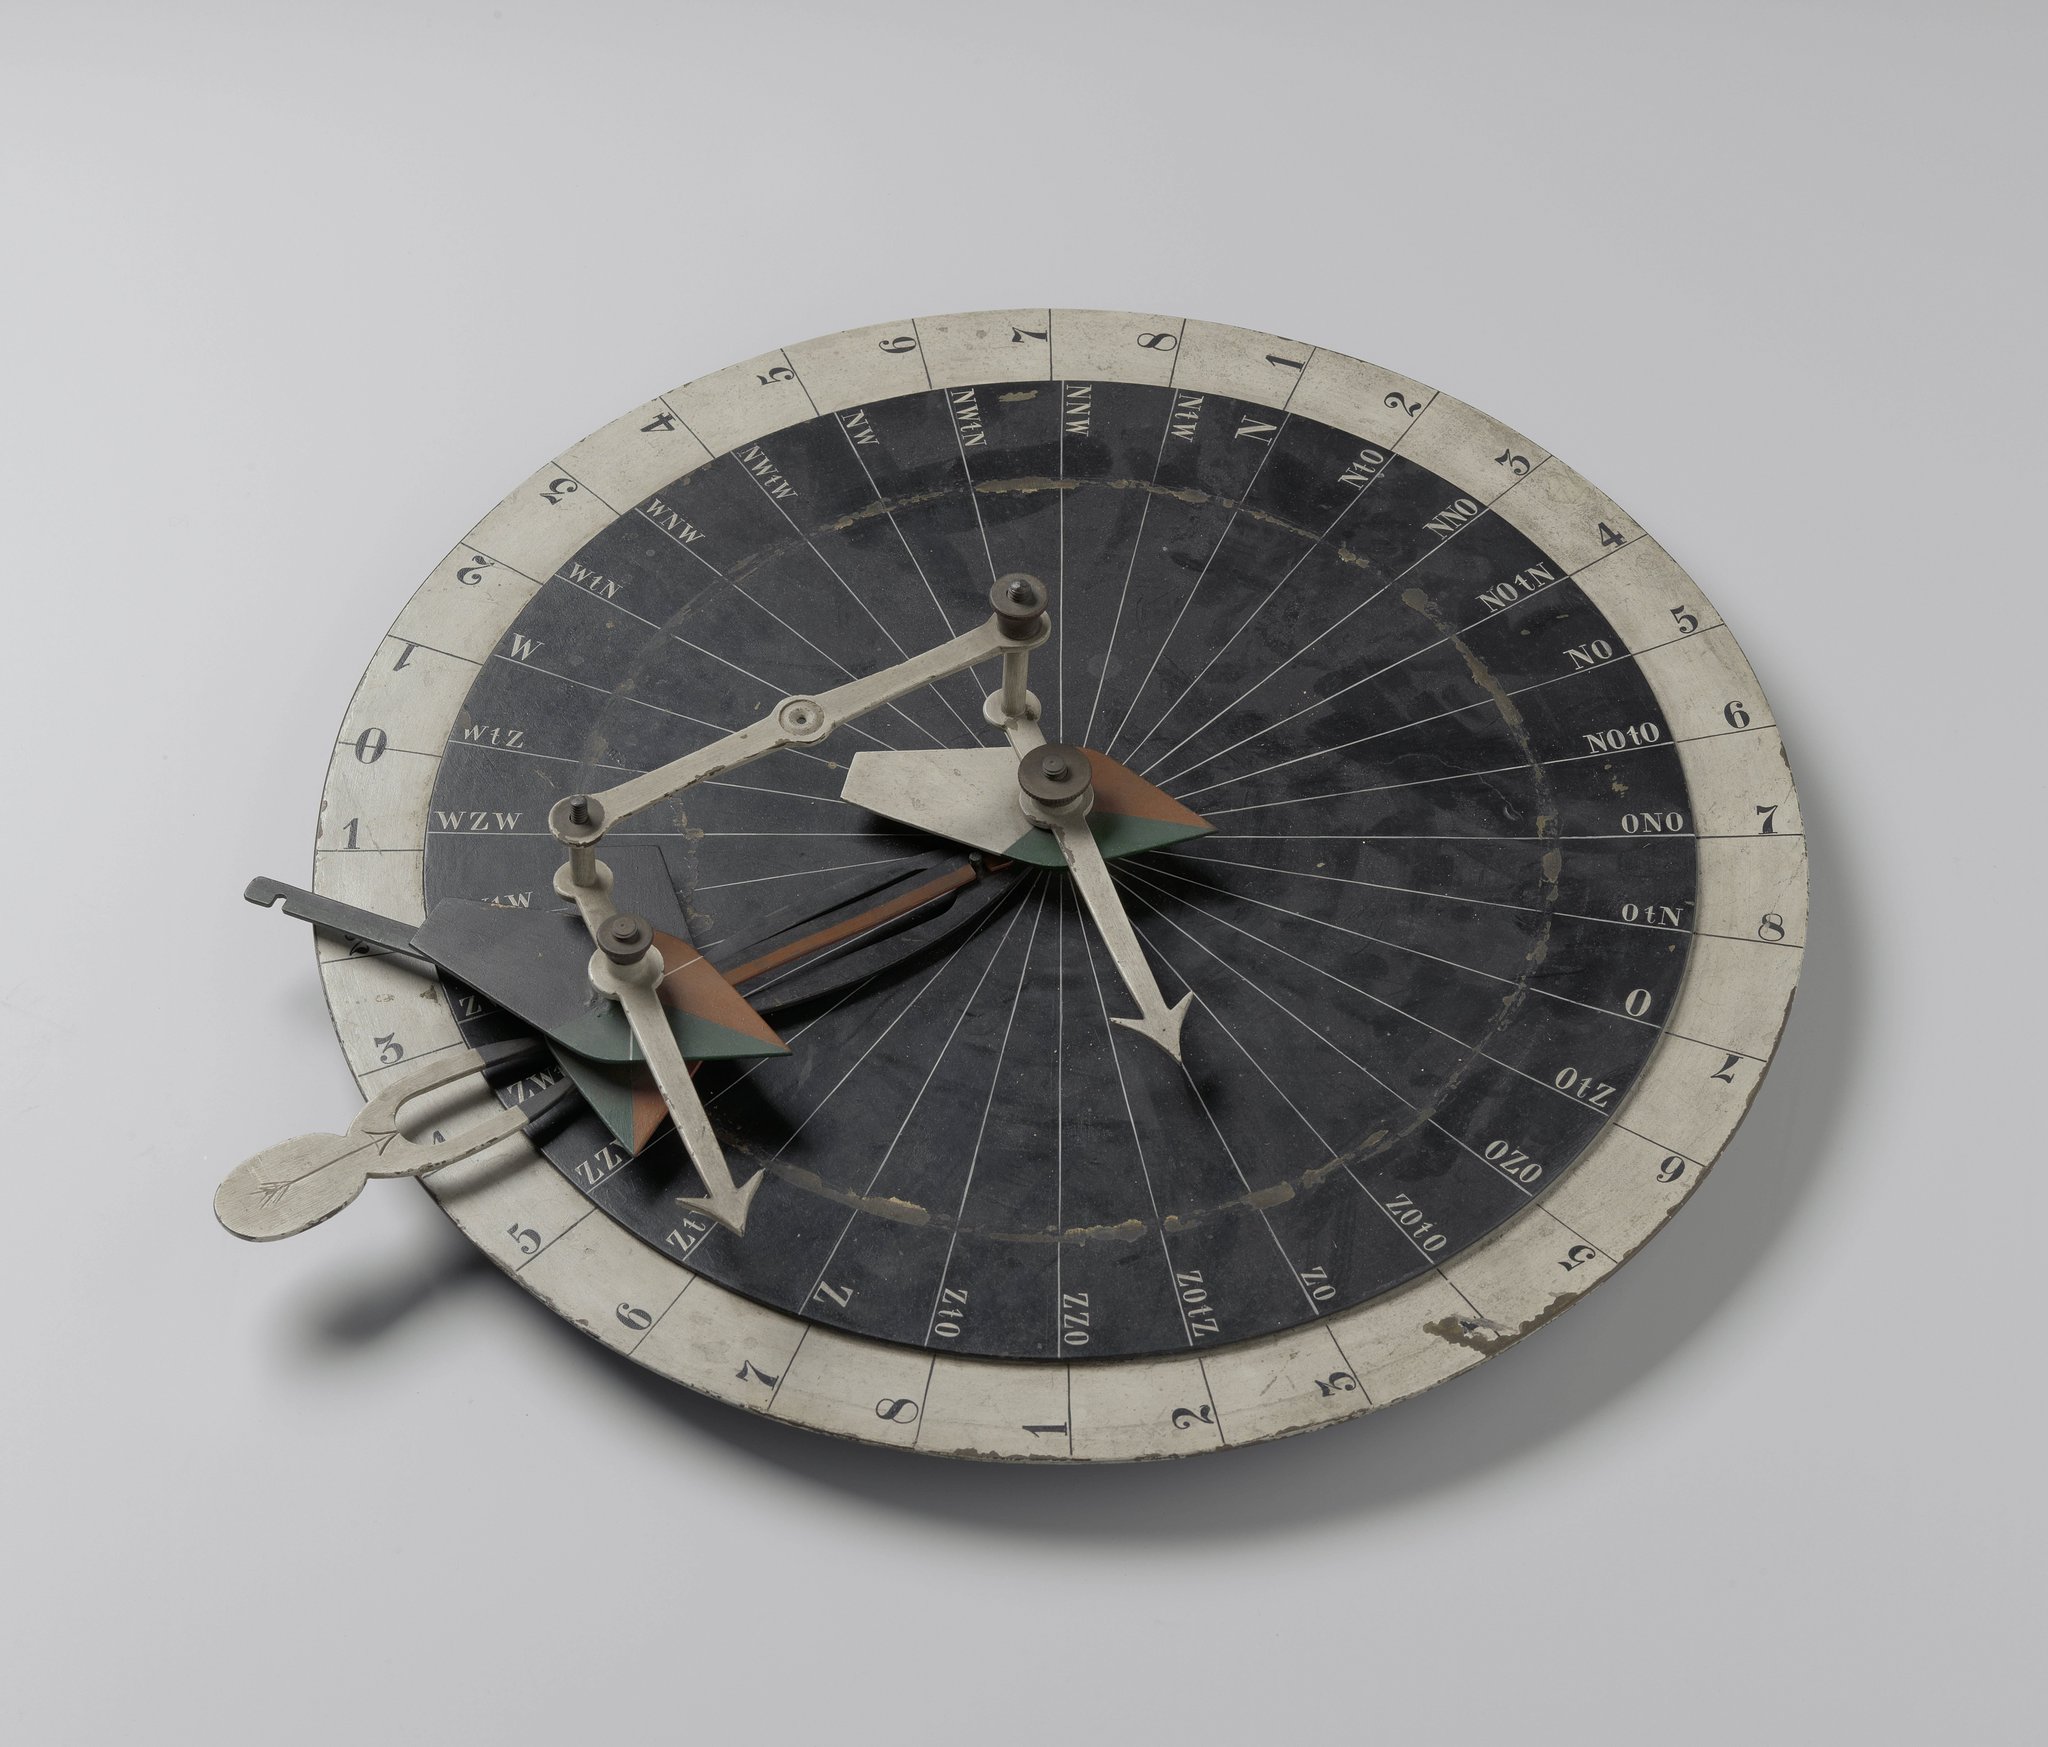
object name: musical instrument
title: Instructie-instrument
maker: Anonymous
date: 1850-1900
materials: brass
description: Grote koperen cirkel op drie pootjes, witgeschilderd. Hierop een zwarte cirkel, waarop een draaiarm met complex systeem van verstelbare pijlen en een naald. In het middelpunt een bootvorm.